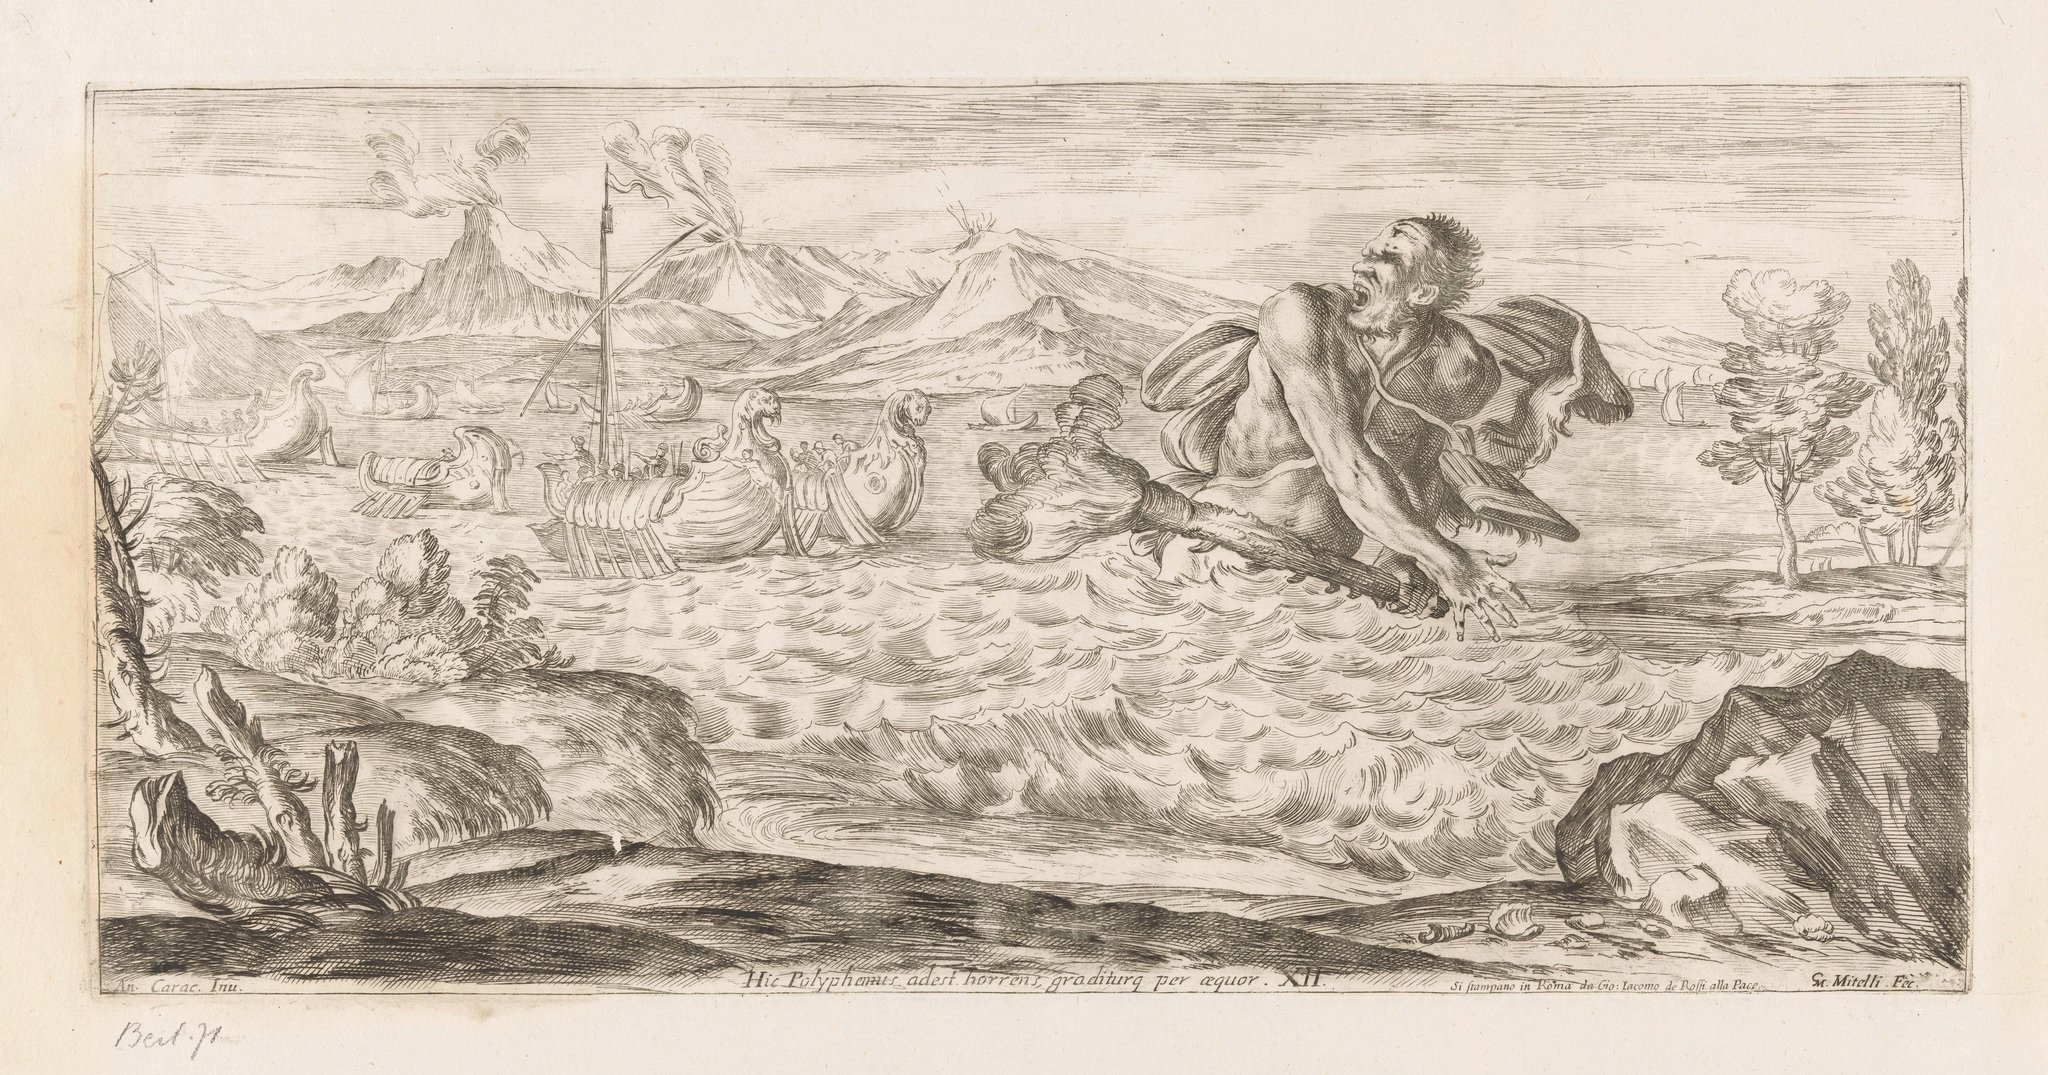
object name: print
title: Omzwervingen van Aeneas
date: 1663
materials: paper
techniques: etching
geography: italy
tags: the trojans escape from polyphemus and the cyclopes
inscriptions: collector's mark: Lugt 2228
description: Deze prent maakt deel uit van een reeks van 20 prenten (+ titelprent) naar de fresco's door de Carracci's in Palazzo Fava Ghisilieri te Bologna.